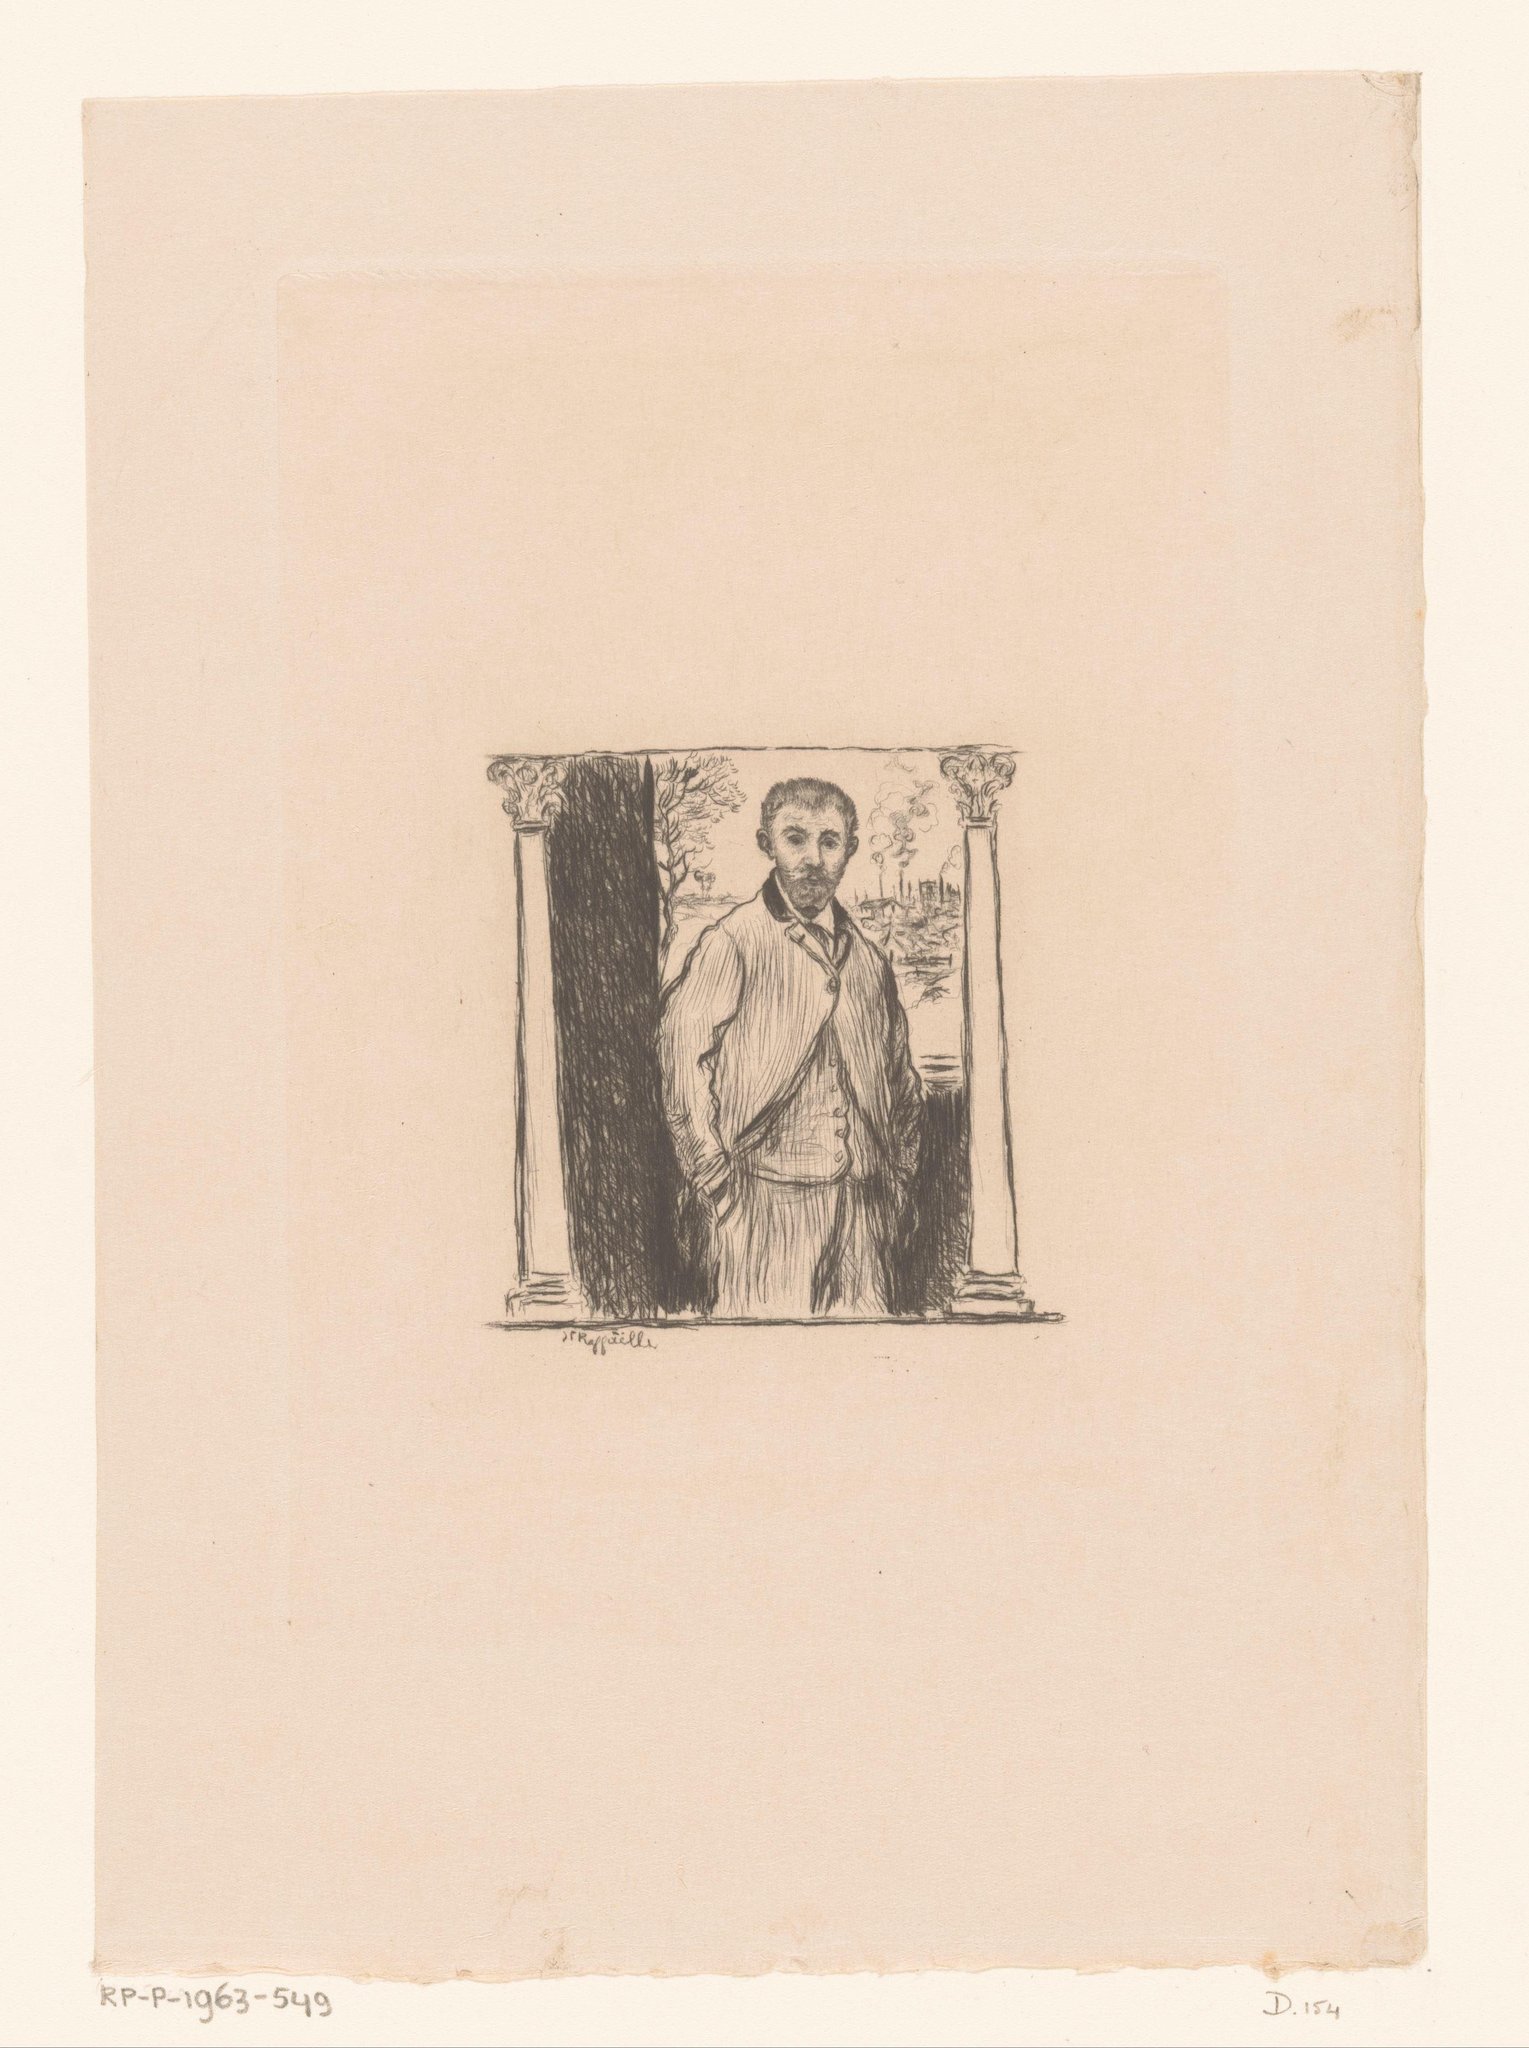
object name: print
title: Portret van Joris-Karl Huysmans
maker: jean françois raffaëlli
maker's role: print maker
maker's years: 1850-1924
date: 1860-1924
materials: paper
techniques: etching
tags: paris, joris-karl huysmans, historical persons, portrait of a writer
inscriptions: collector's mark: Lugt 2228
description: Ets voor de titelpagina van: Huysmans, Joris-Karl. Les Soeurs Vatard. Parijs: A. Ferroud, 1909.